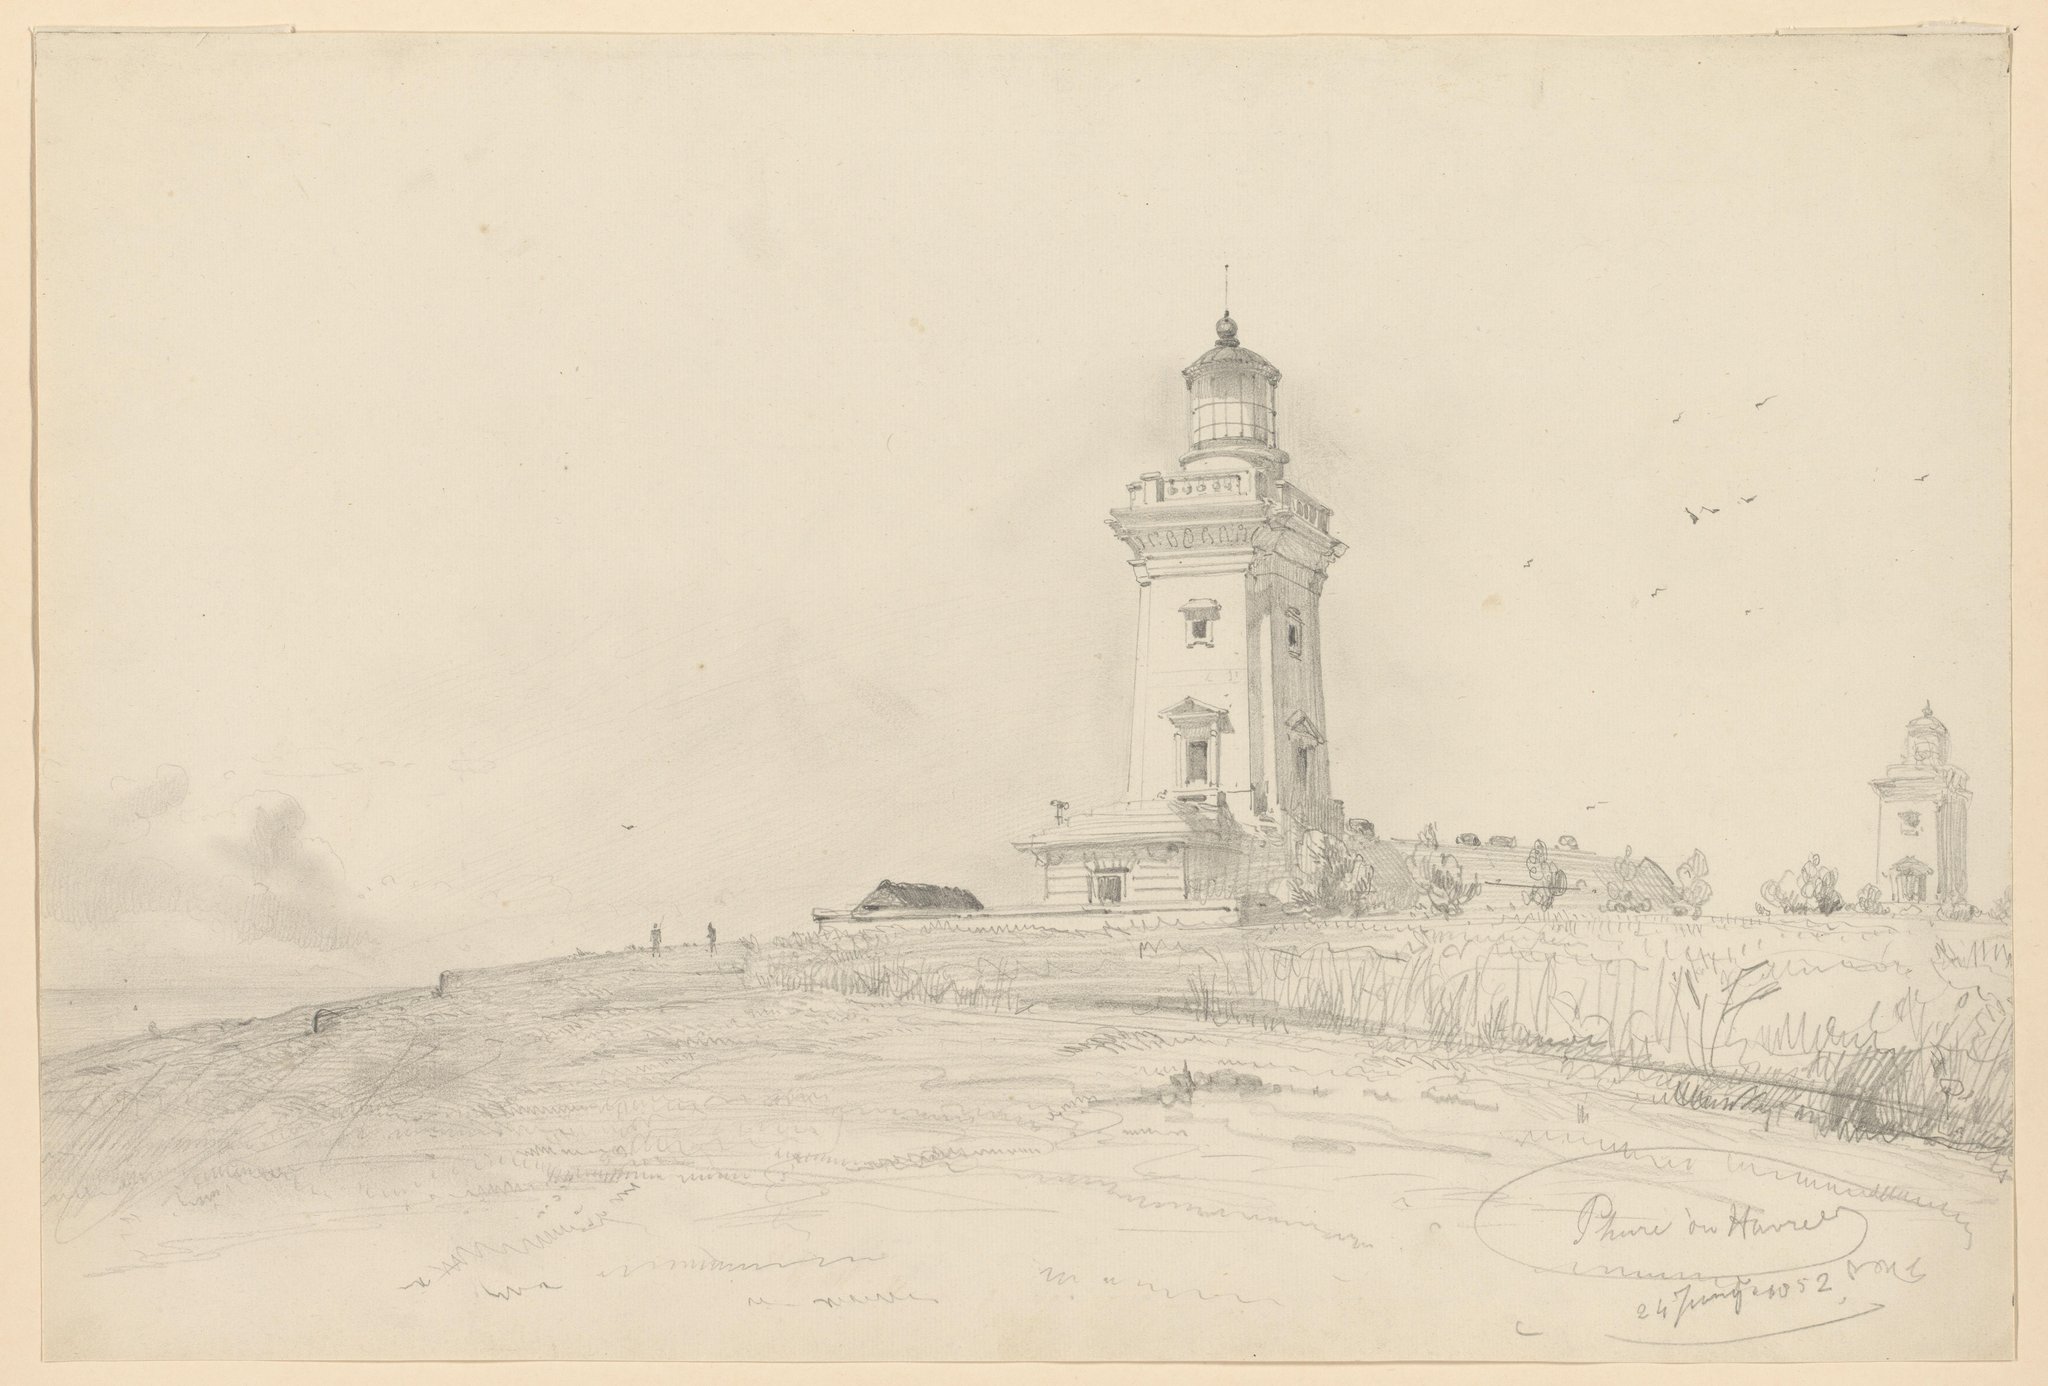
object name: drawing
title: Vuurtoren van Le Havre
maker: willem anthonie van deventer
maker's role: draughtsman, painter, print maker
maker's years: 1824-1893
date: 1852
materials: paper, pencil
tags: lighthouse, lightship, le havre